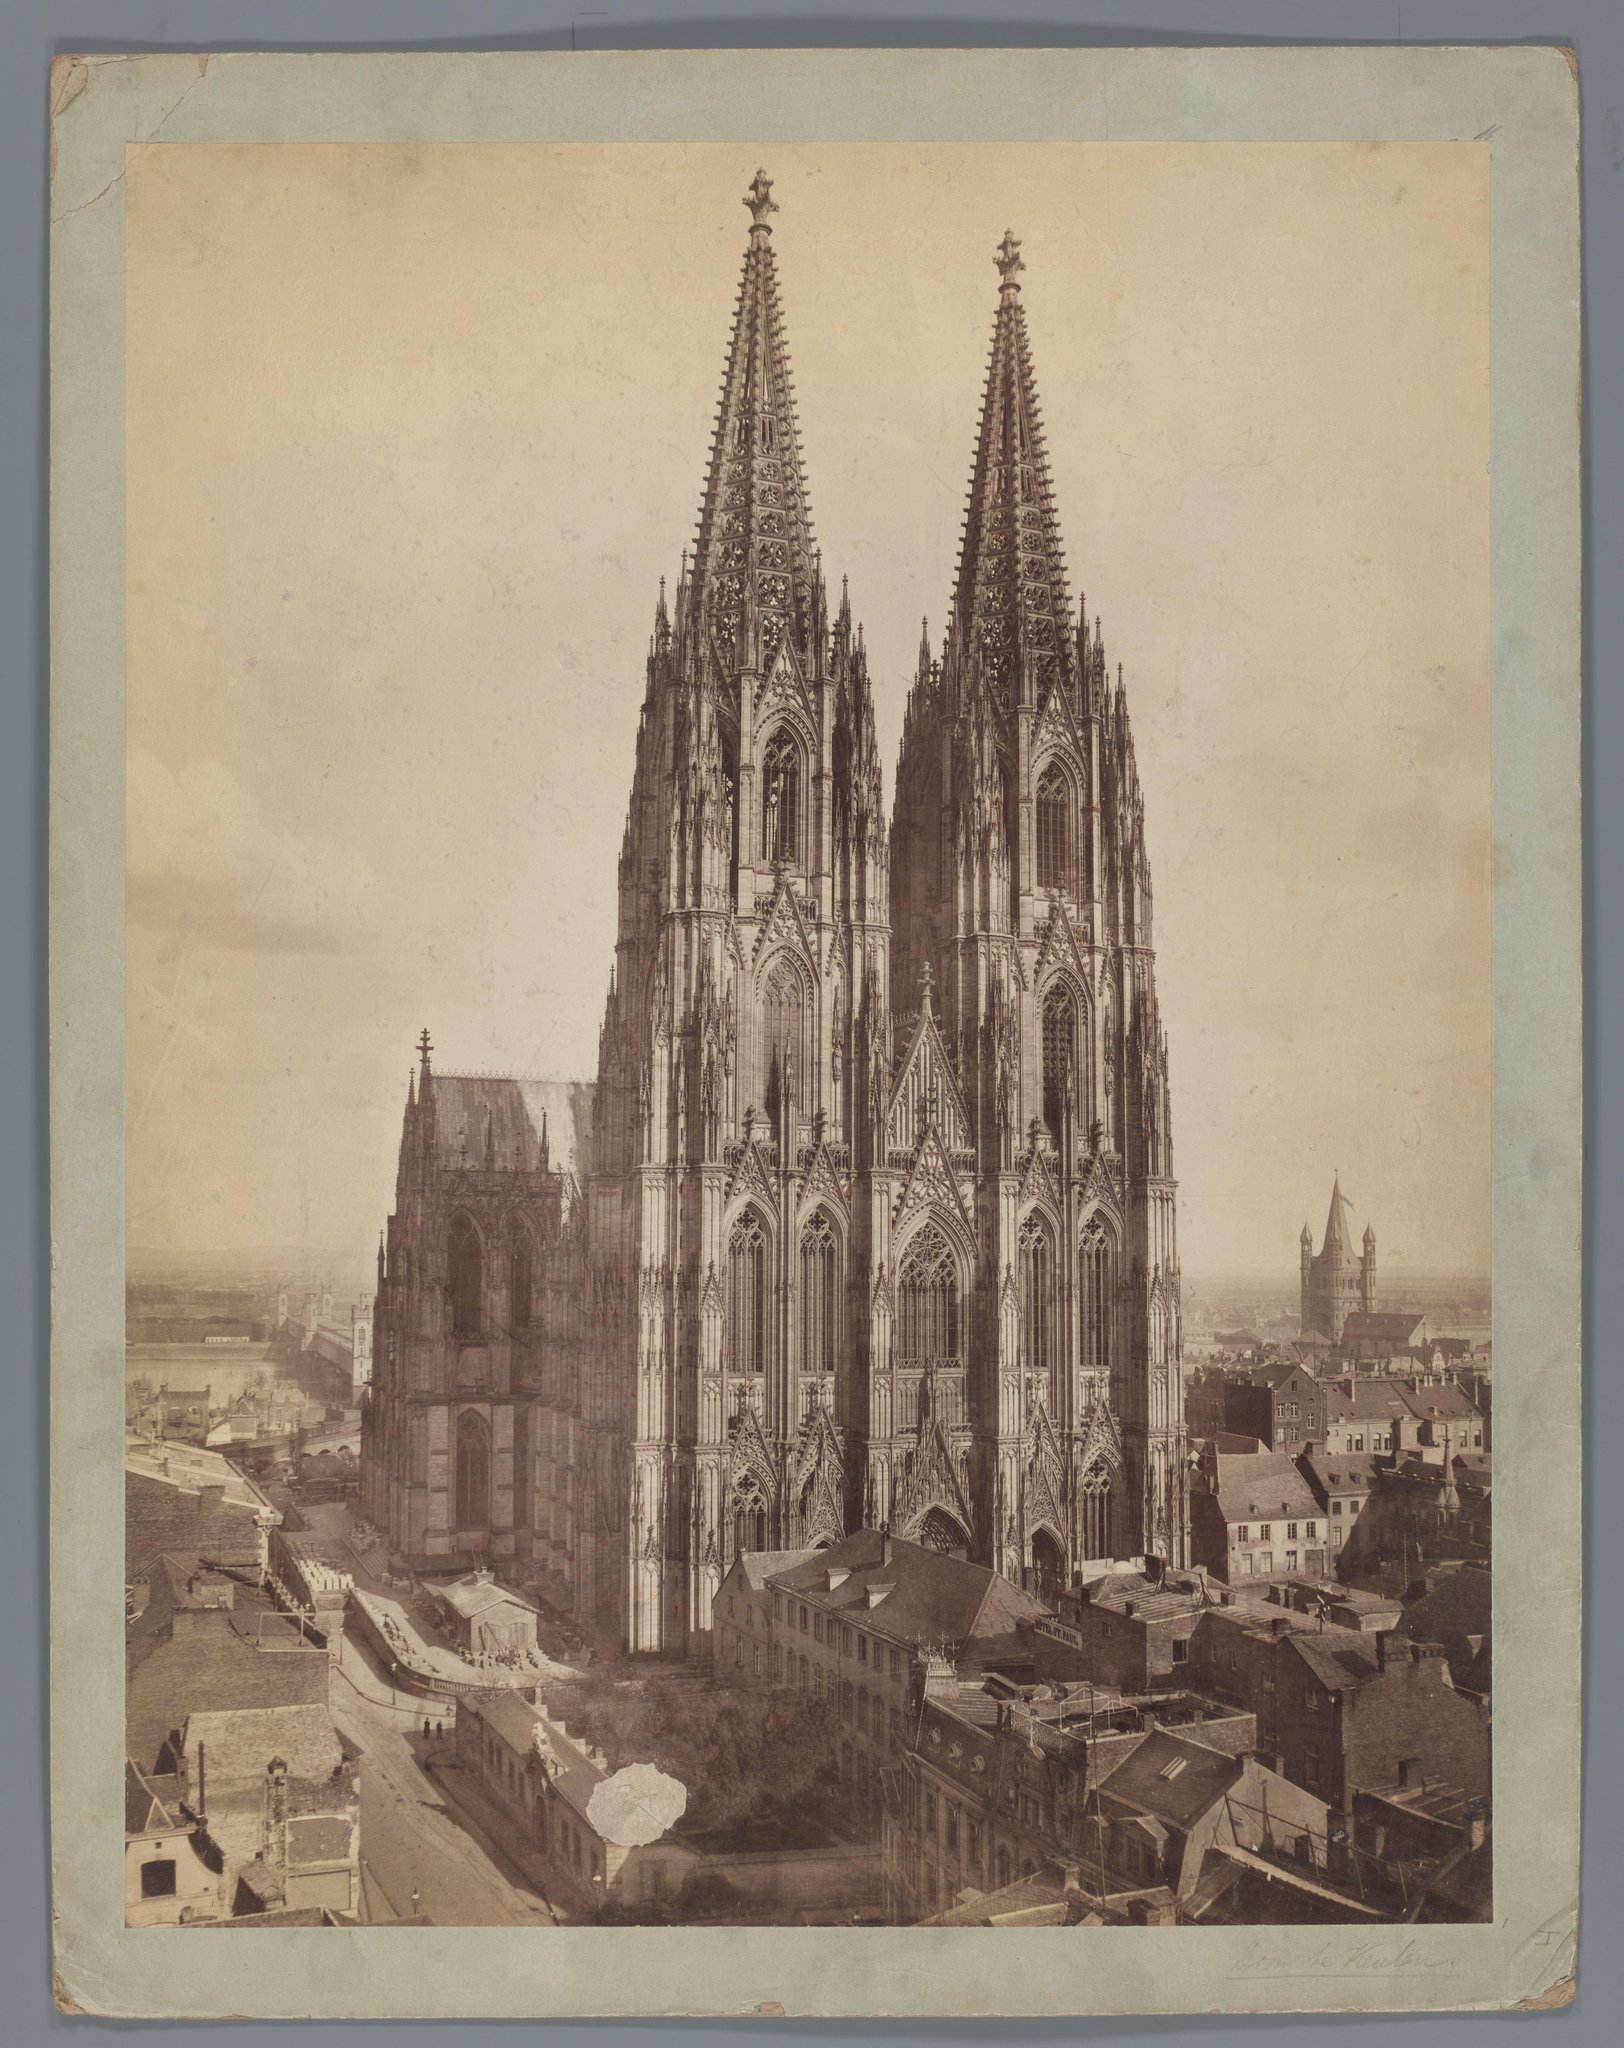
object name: photograph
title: Gezicht op de Dom van Keulen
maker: Anonymous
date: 1880-1910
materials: cardboard, photographic support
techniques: albumen print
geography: cologne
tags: church (exterior)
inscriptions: annotation: ‘Dom te Keulen’, annotation: ‘[...] B. Kunst/ maandag 2 nov '03 en 9 nov '03/ [...]/ maandag 7 nov '04’, collector's mark: Lugt 3937